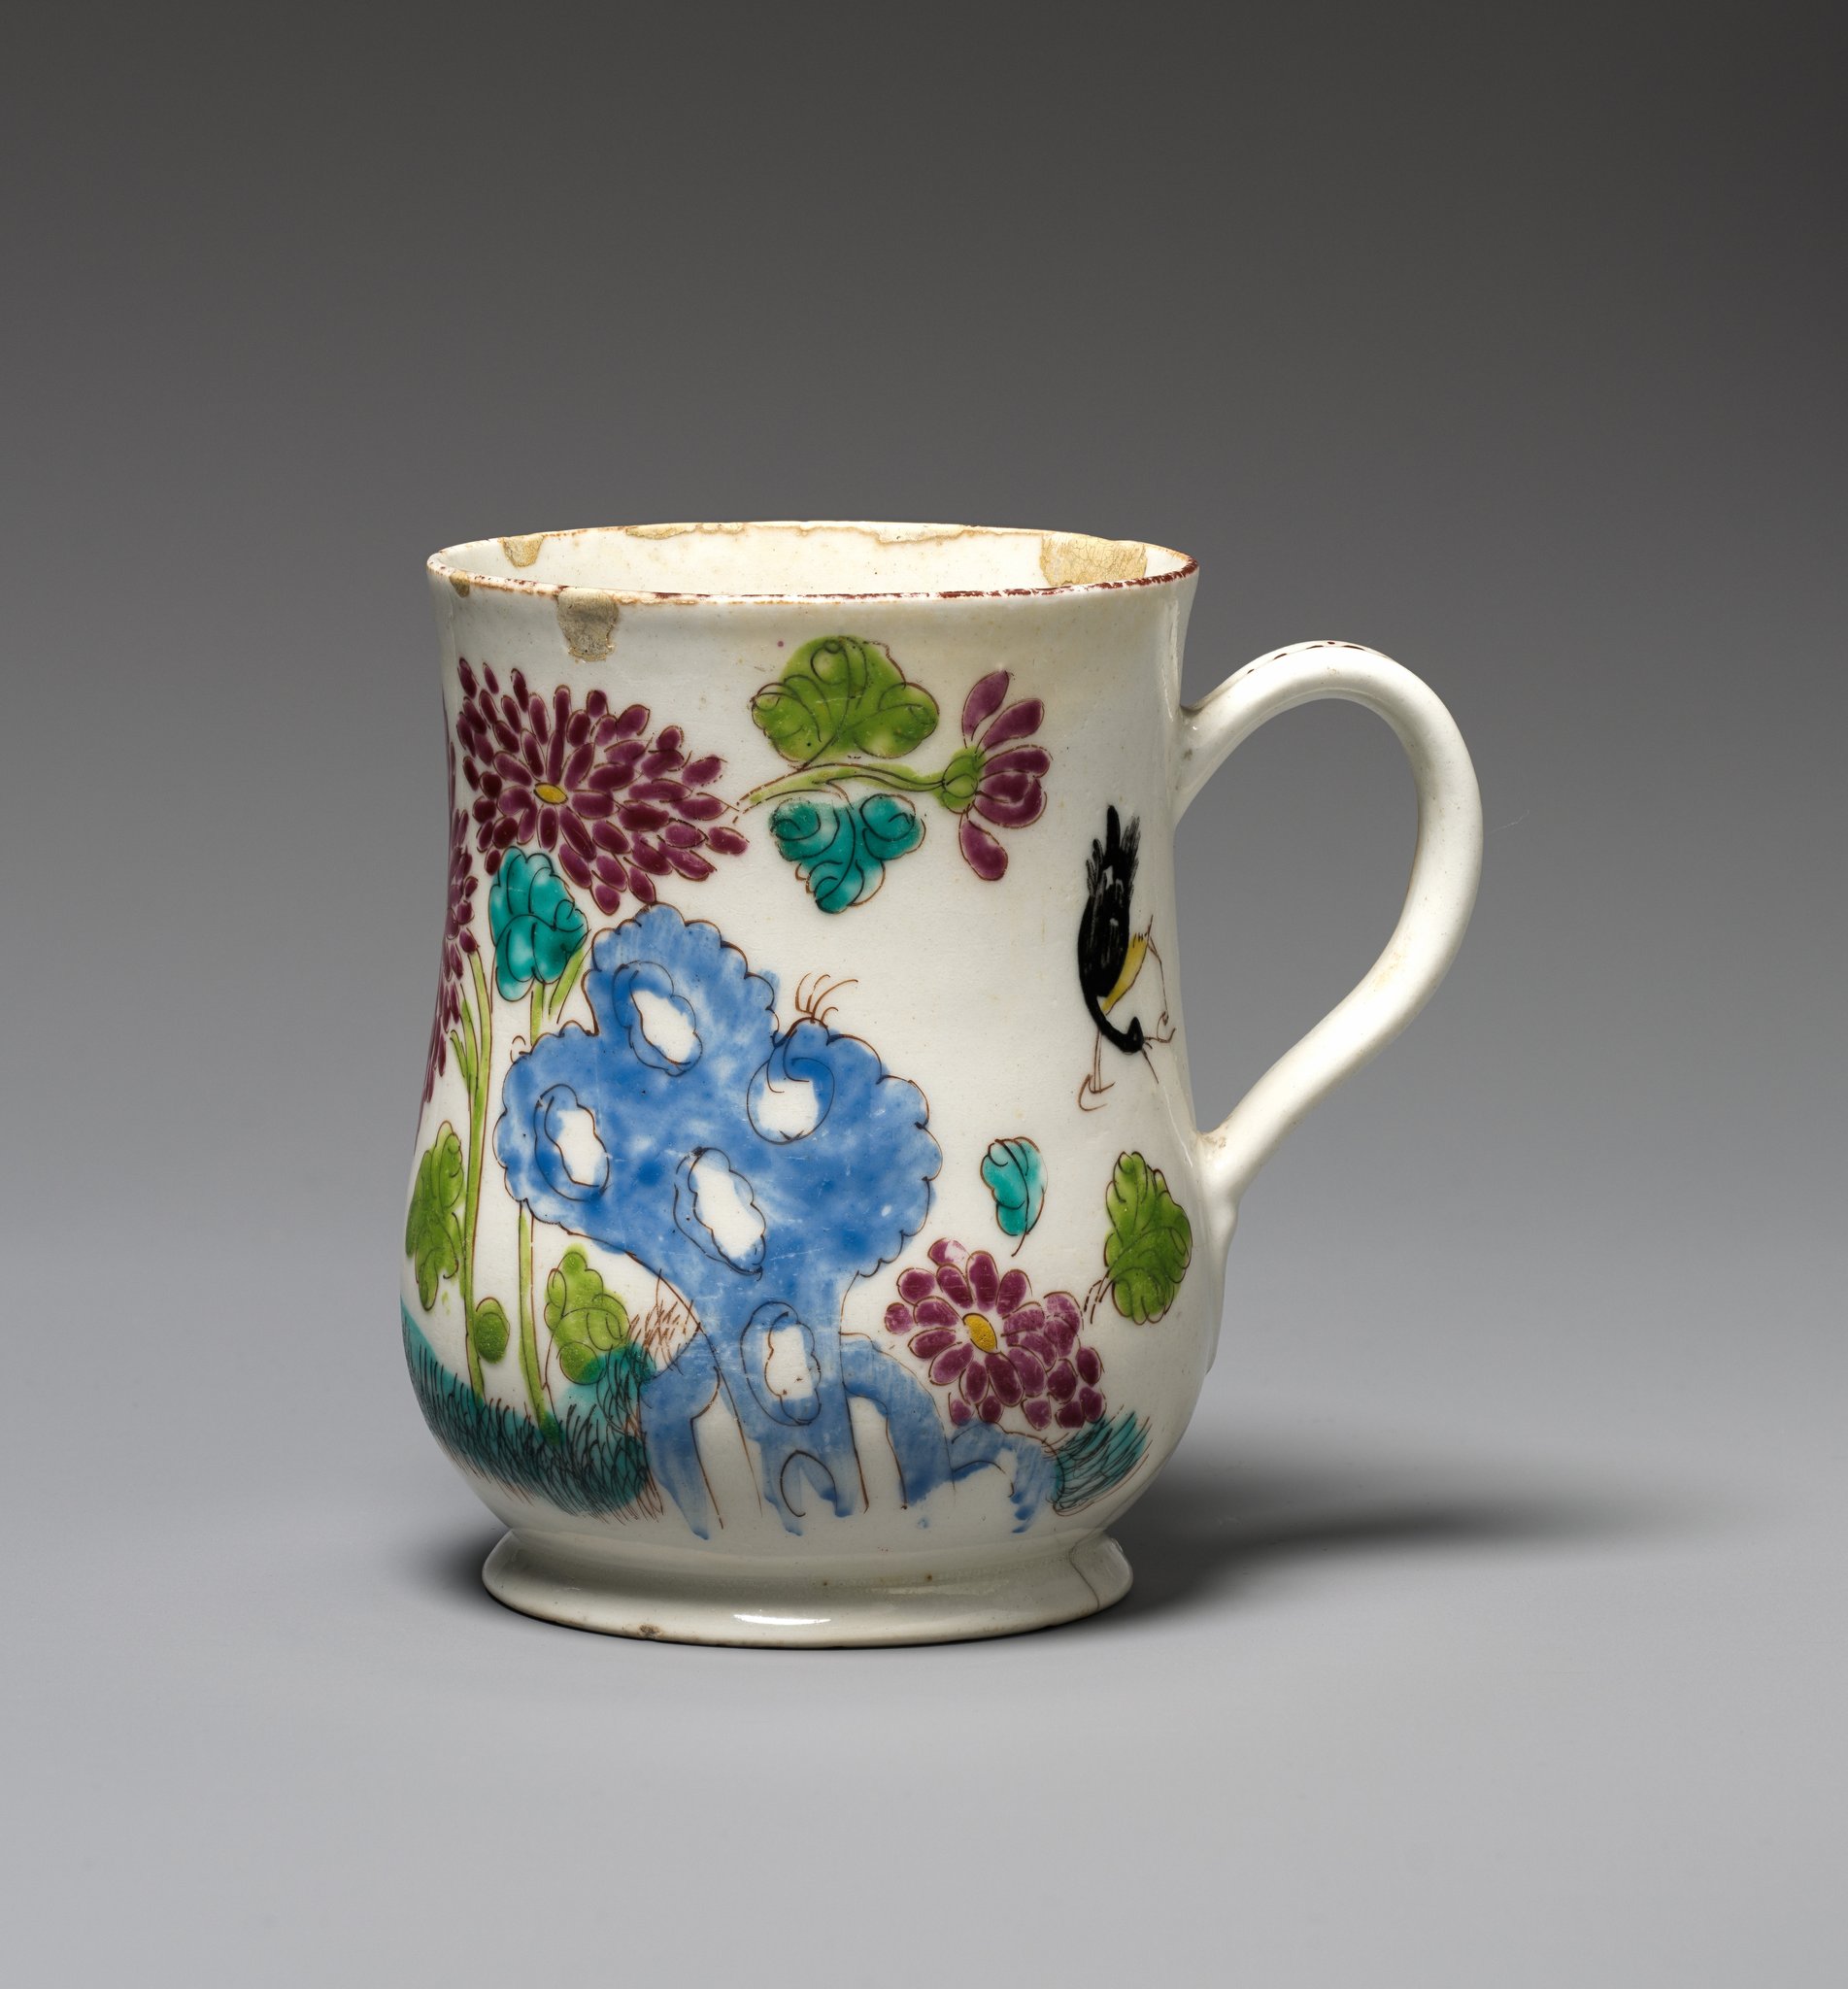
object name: mug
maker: bow porcelain factory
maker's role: factory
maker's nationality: british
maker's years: 1747-1776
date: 1755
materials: soft paste porcelain